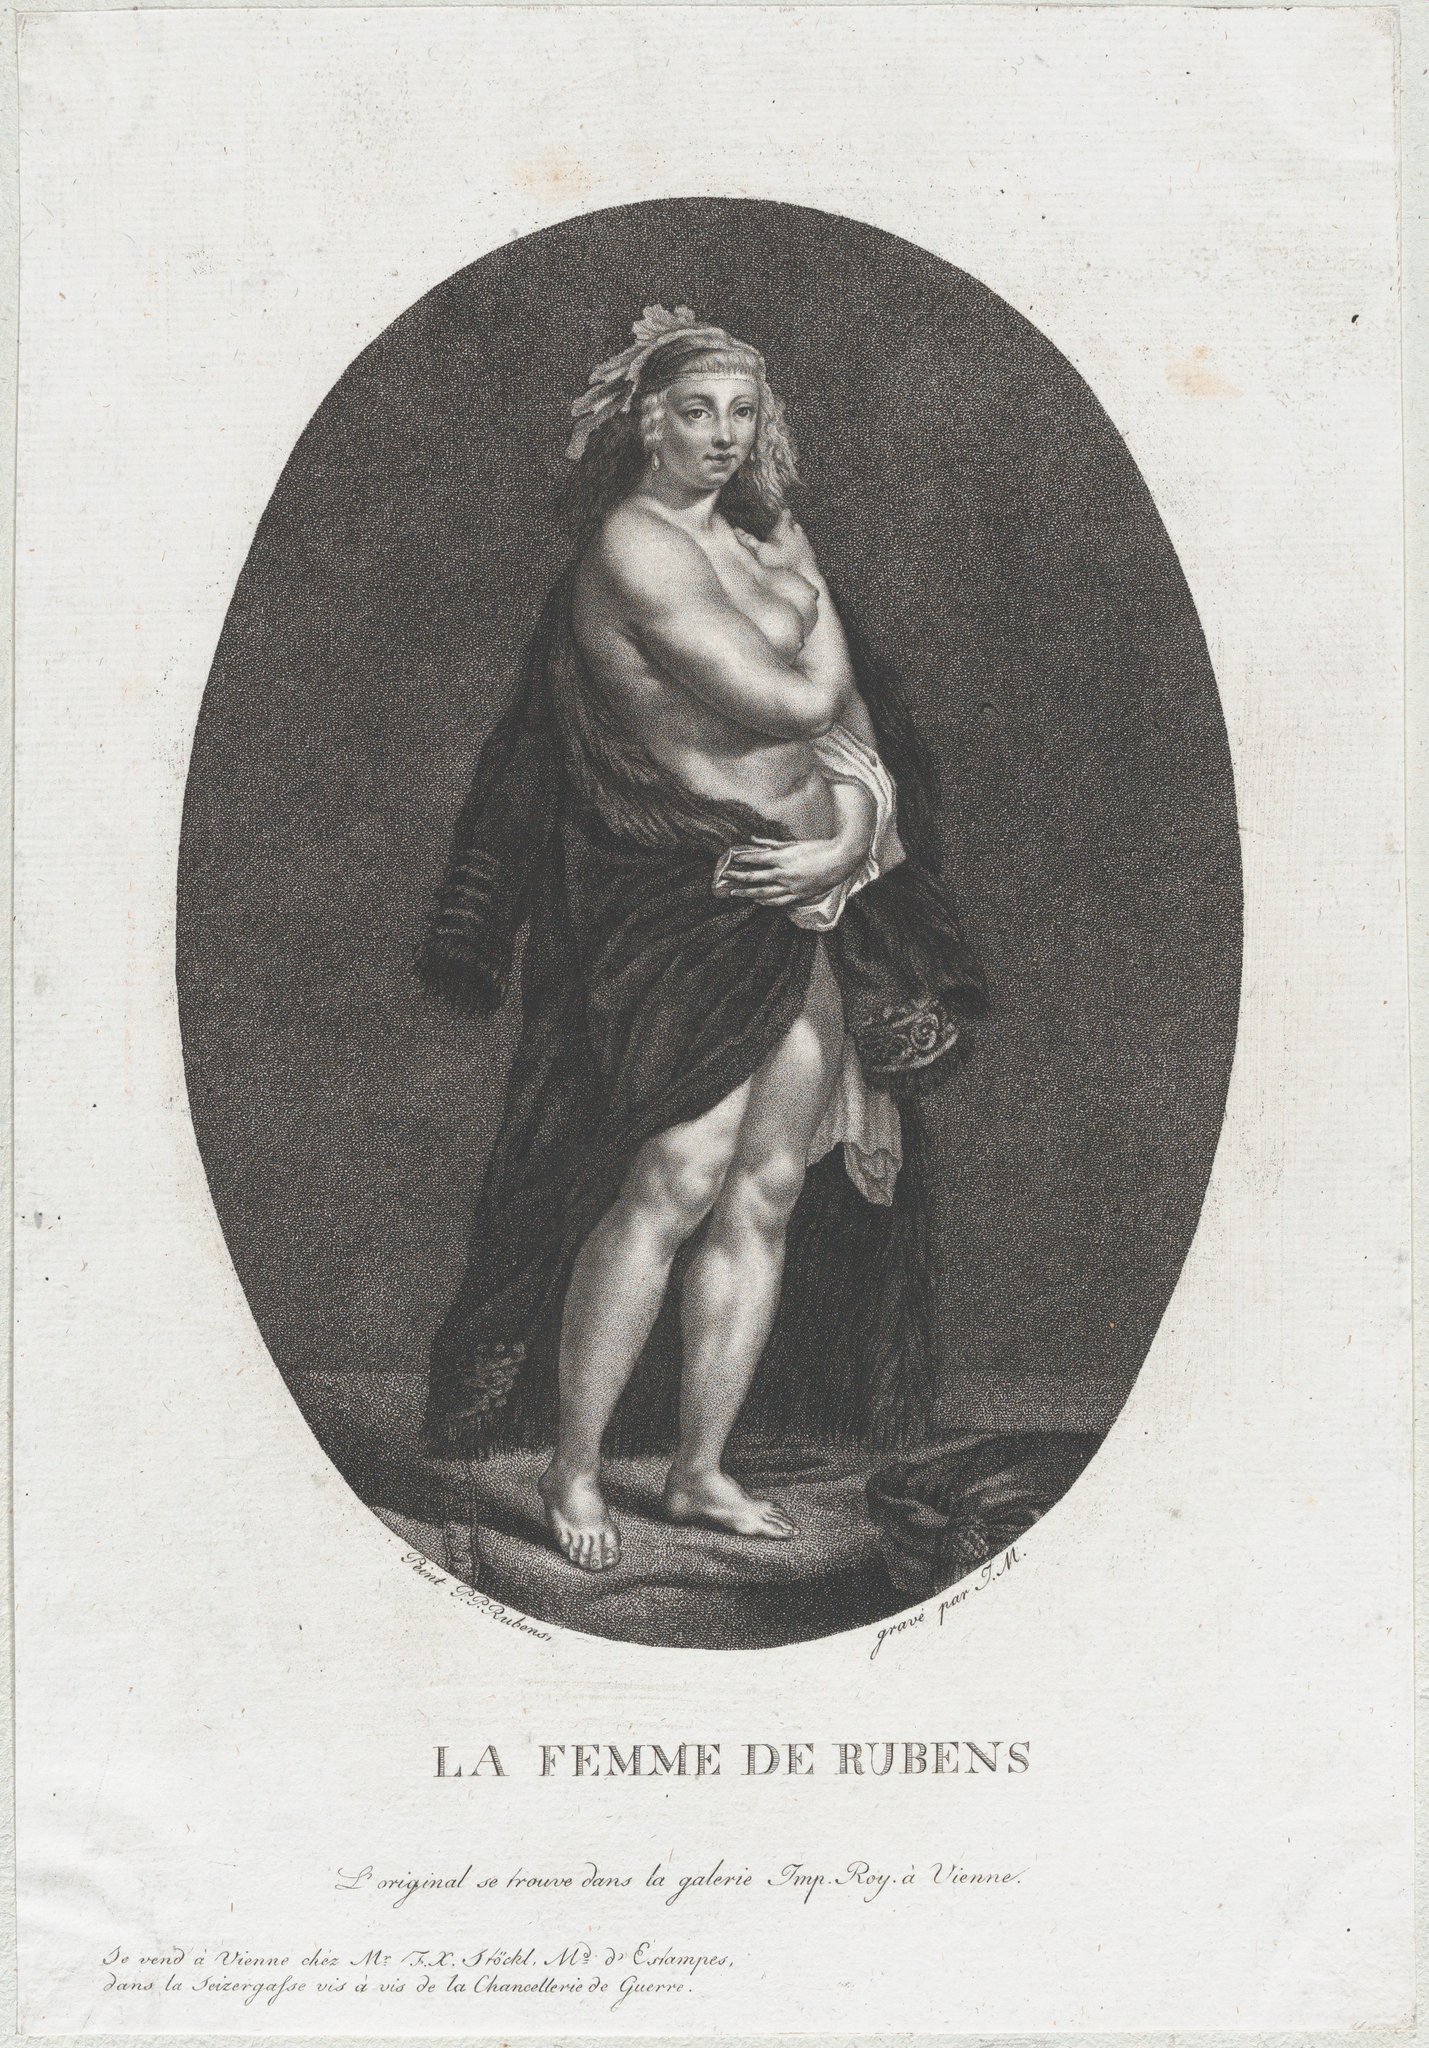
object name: print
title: Portrait of Helena Fourment, Rubens' second wife, wearing a fur coat over her shoulders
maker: jakob mettenleiter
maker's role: artist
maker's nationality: german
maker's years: 1750-1825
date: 1786-1815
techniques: engraving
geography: vienna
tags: portraits,women